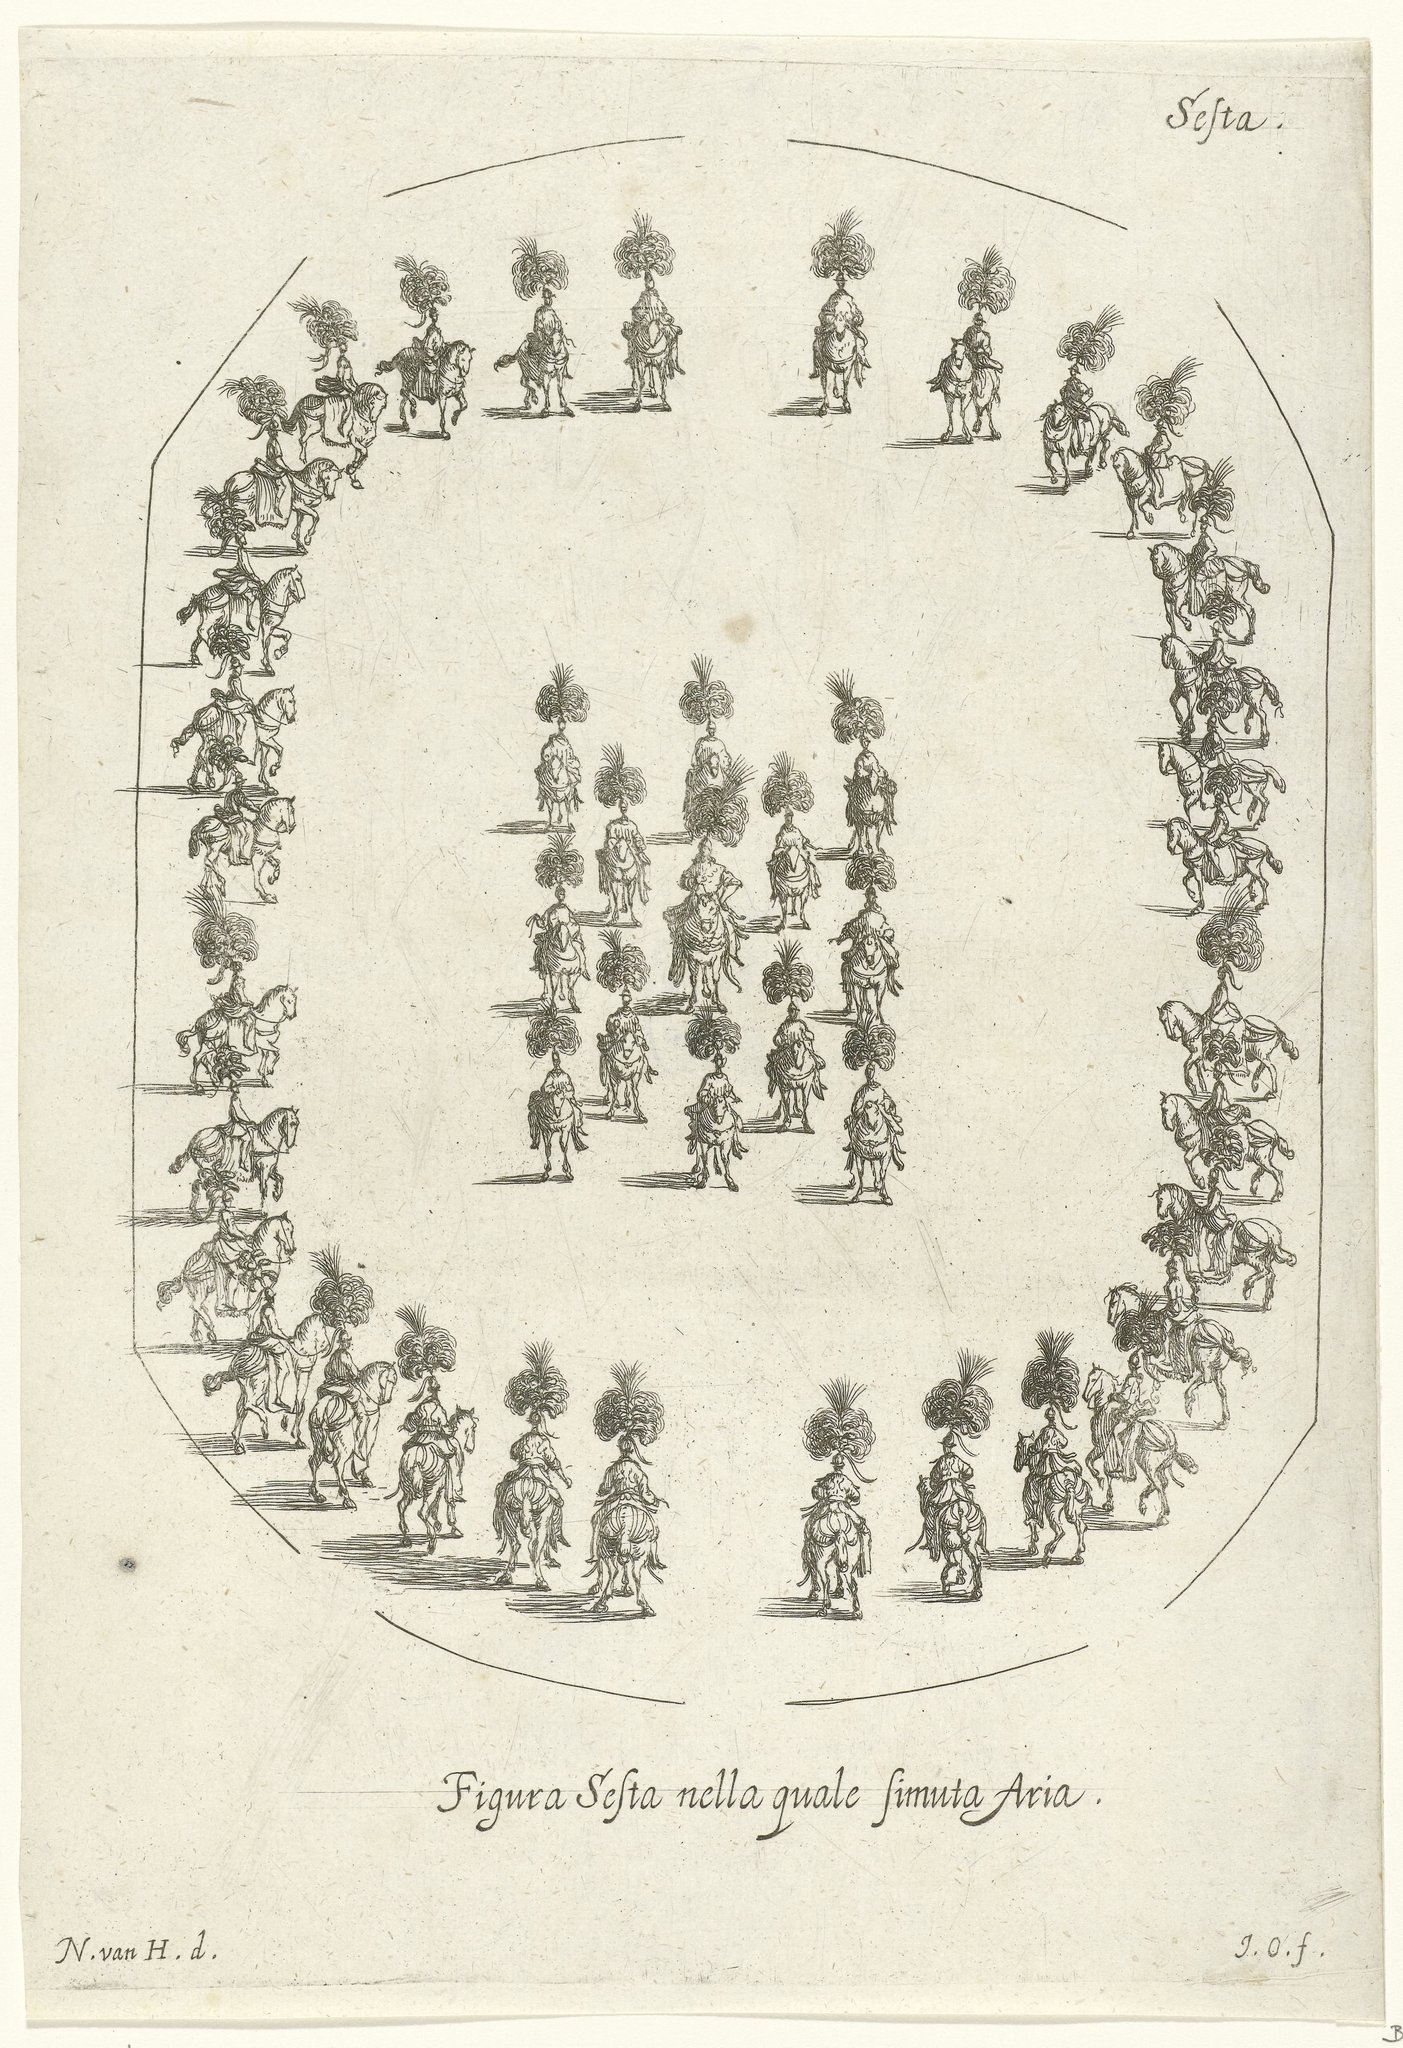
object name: print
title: Ruiterformaties (Sesta)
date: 1667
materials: paper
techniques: etching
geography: vienna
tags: high-school riding, military honours (+ cavalry, horsemen)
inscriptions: collector's mark: Lugt 2228